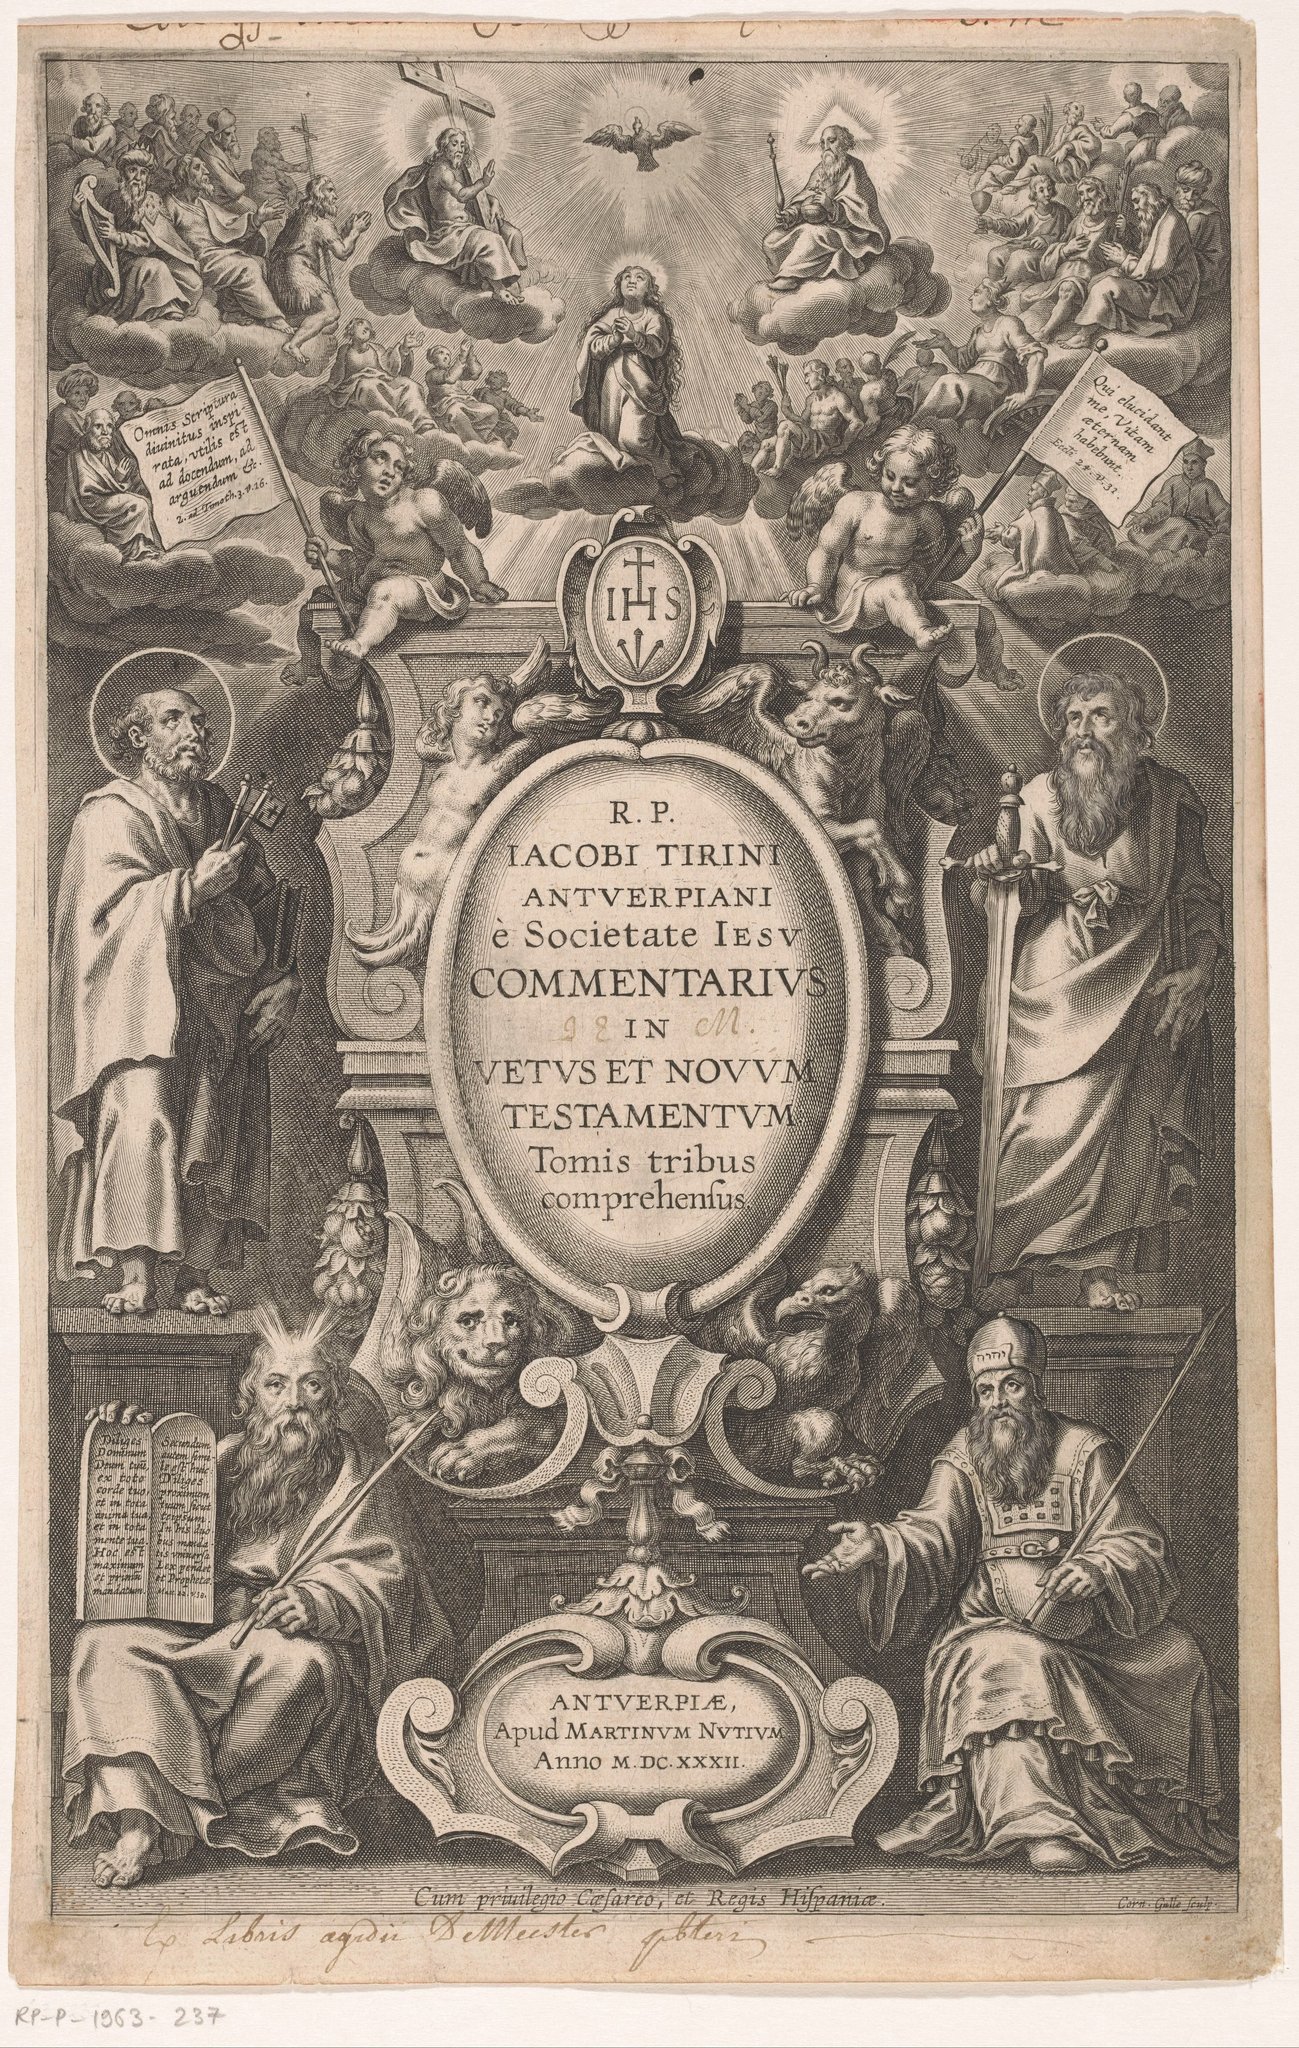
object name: print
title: Titelpagina voor: J. Tirinus, Commentarius in Vetus et Novum Testamentum, Antwerpen, M. Nutius, 1632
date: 1632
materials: paper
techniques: engraving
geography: antwerp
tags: the four symbols of the evangelists, 'the apocalyptic beasts', aaron (not in biblical context); possible attributes: attributes of aaron: censer, dressed as high priest or bishop, ointment jar, rod or flowering wand, moses (not in biblical context); possible attributes: rays of light or horns on his head, rod, tables of the law, the apostle peter, first bishop of rome; possible attributes: book, cock, (upturned) cross, (triple) crozier, fish, key, scroll, ship, tiara, the apostle paul of tarsus; possible attributes: book, scroll, sword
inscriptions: inscription: ‘...Libris ... Meester gulteri’ bezittersaantekening, collector's mark: Lugt 2760, collector's mark: Lugt 2228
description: Op een cartouche die versiert is met de evangelistensymbolen staat de titel van het boek. Aan weerszijden de apostelen Petrus en Paulus. Eronder Mozes en Aaron. In de hemel Maria en God, Christus en de Heilige Geest in de gedaante van een duif omgeven door engelen en bijbelse figuren.